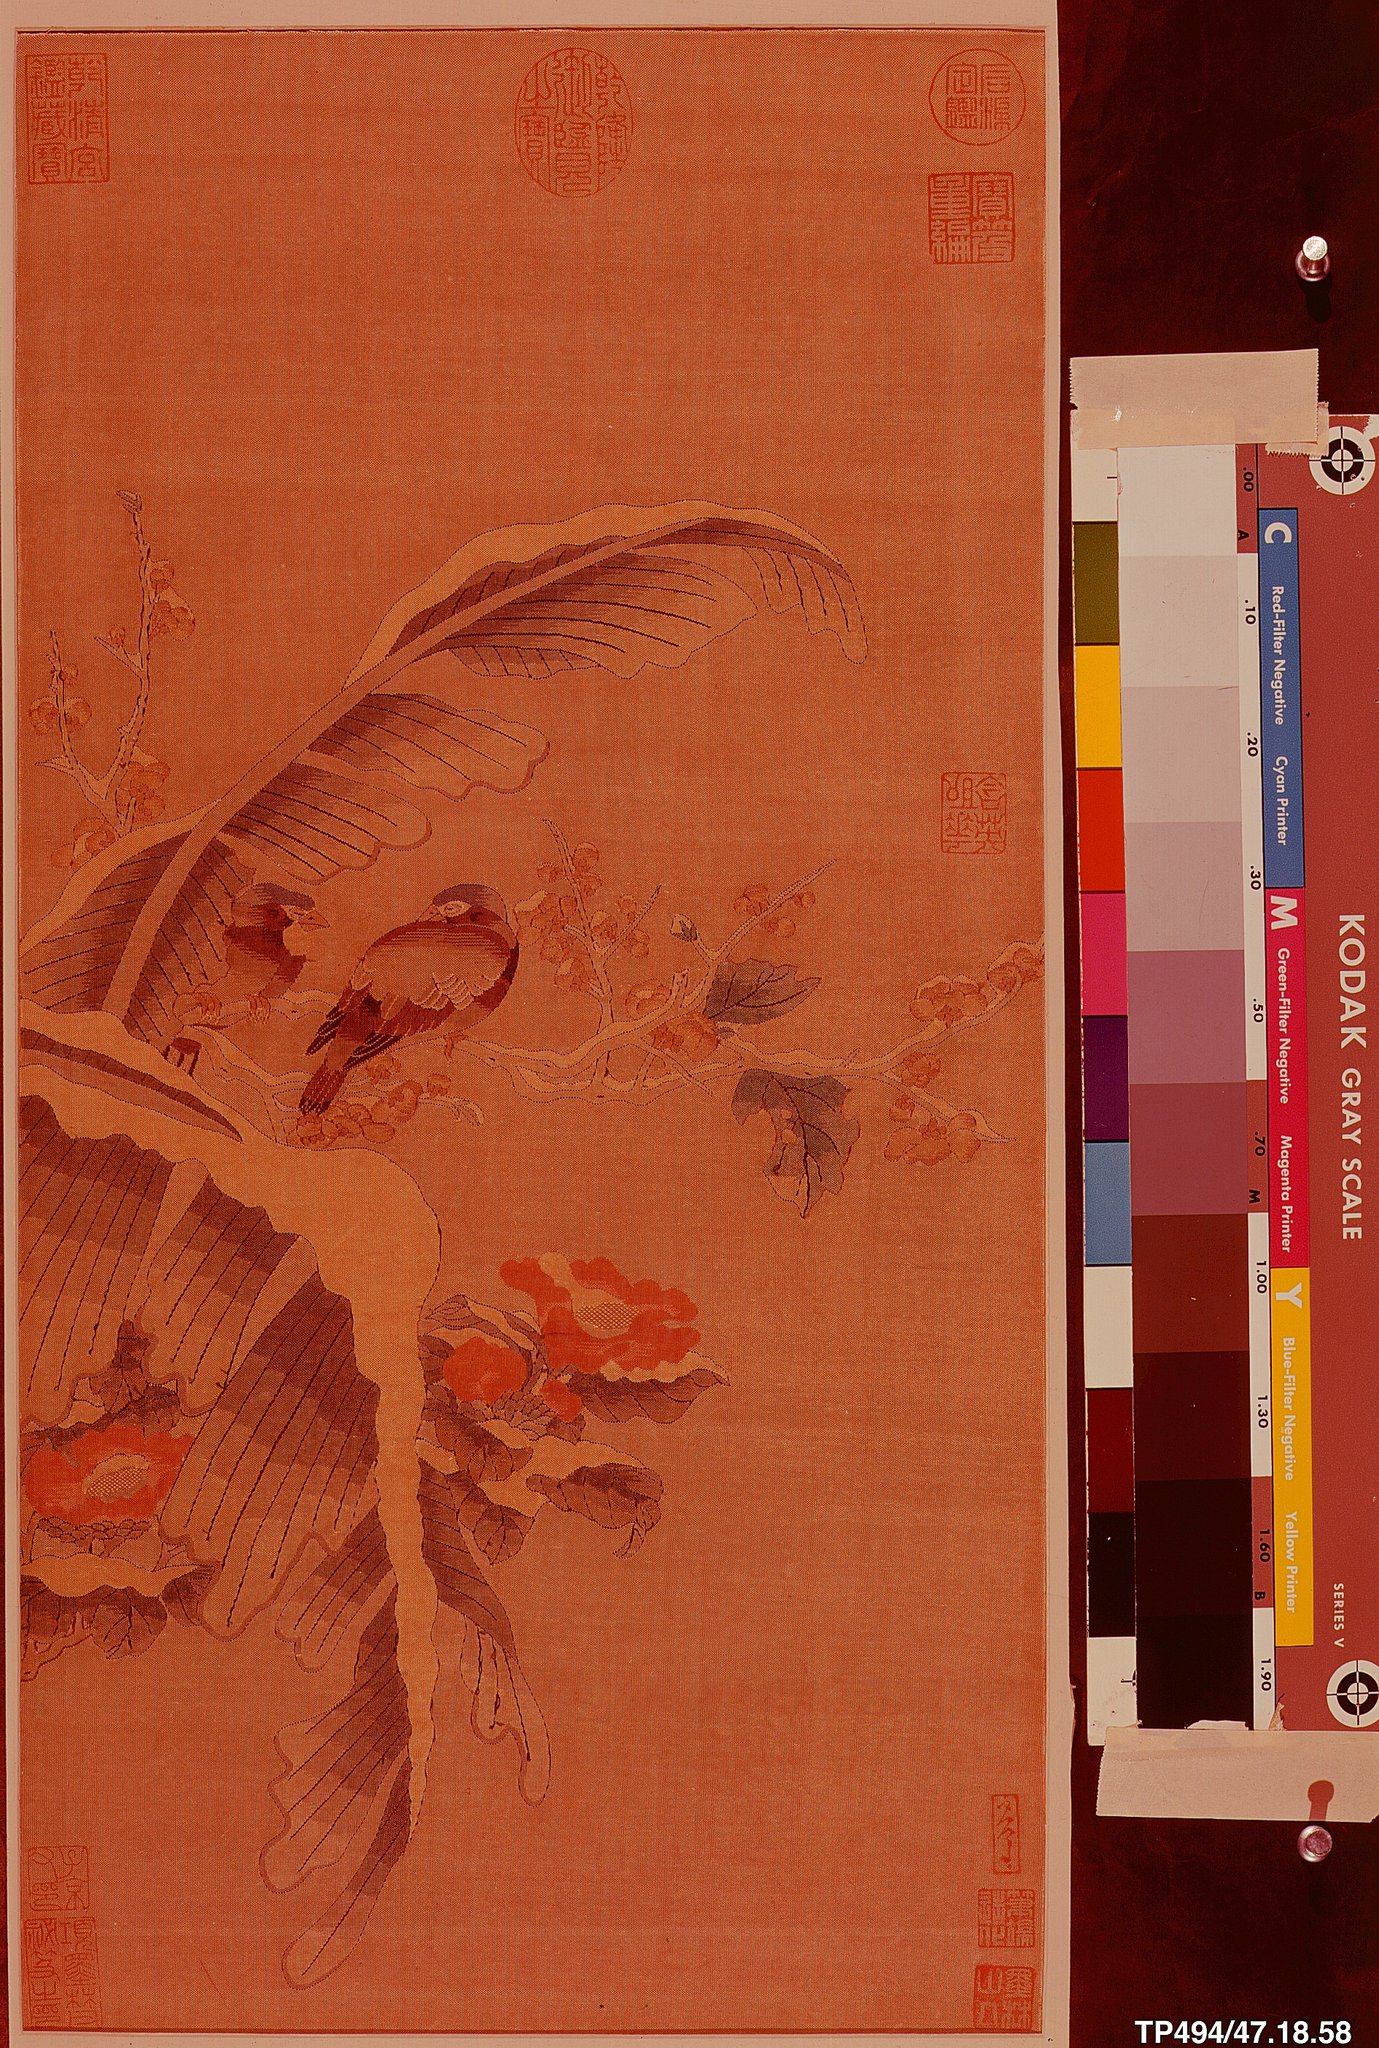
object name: hanging scroll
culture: chinese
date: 1701-1800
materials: silk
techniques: tapestry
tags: birds,scrolls